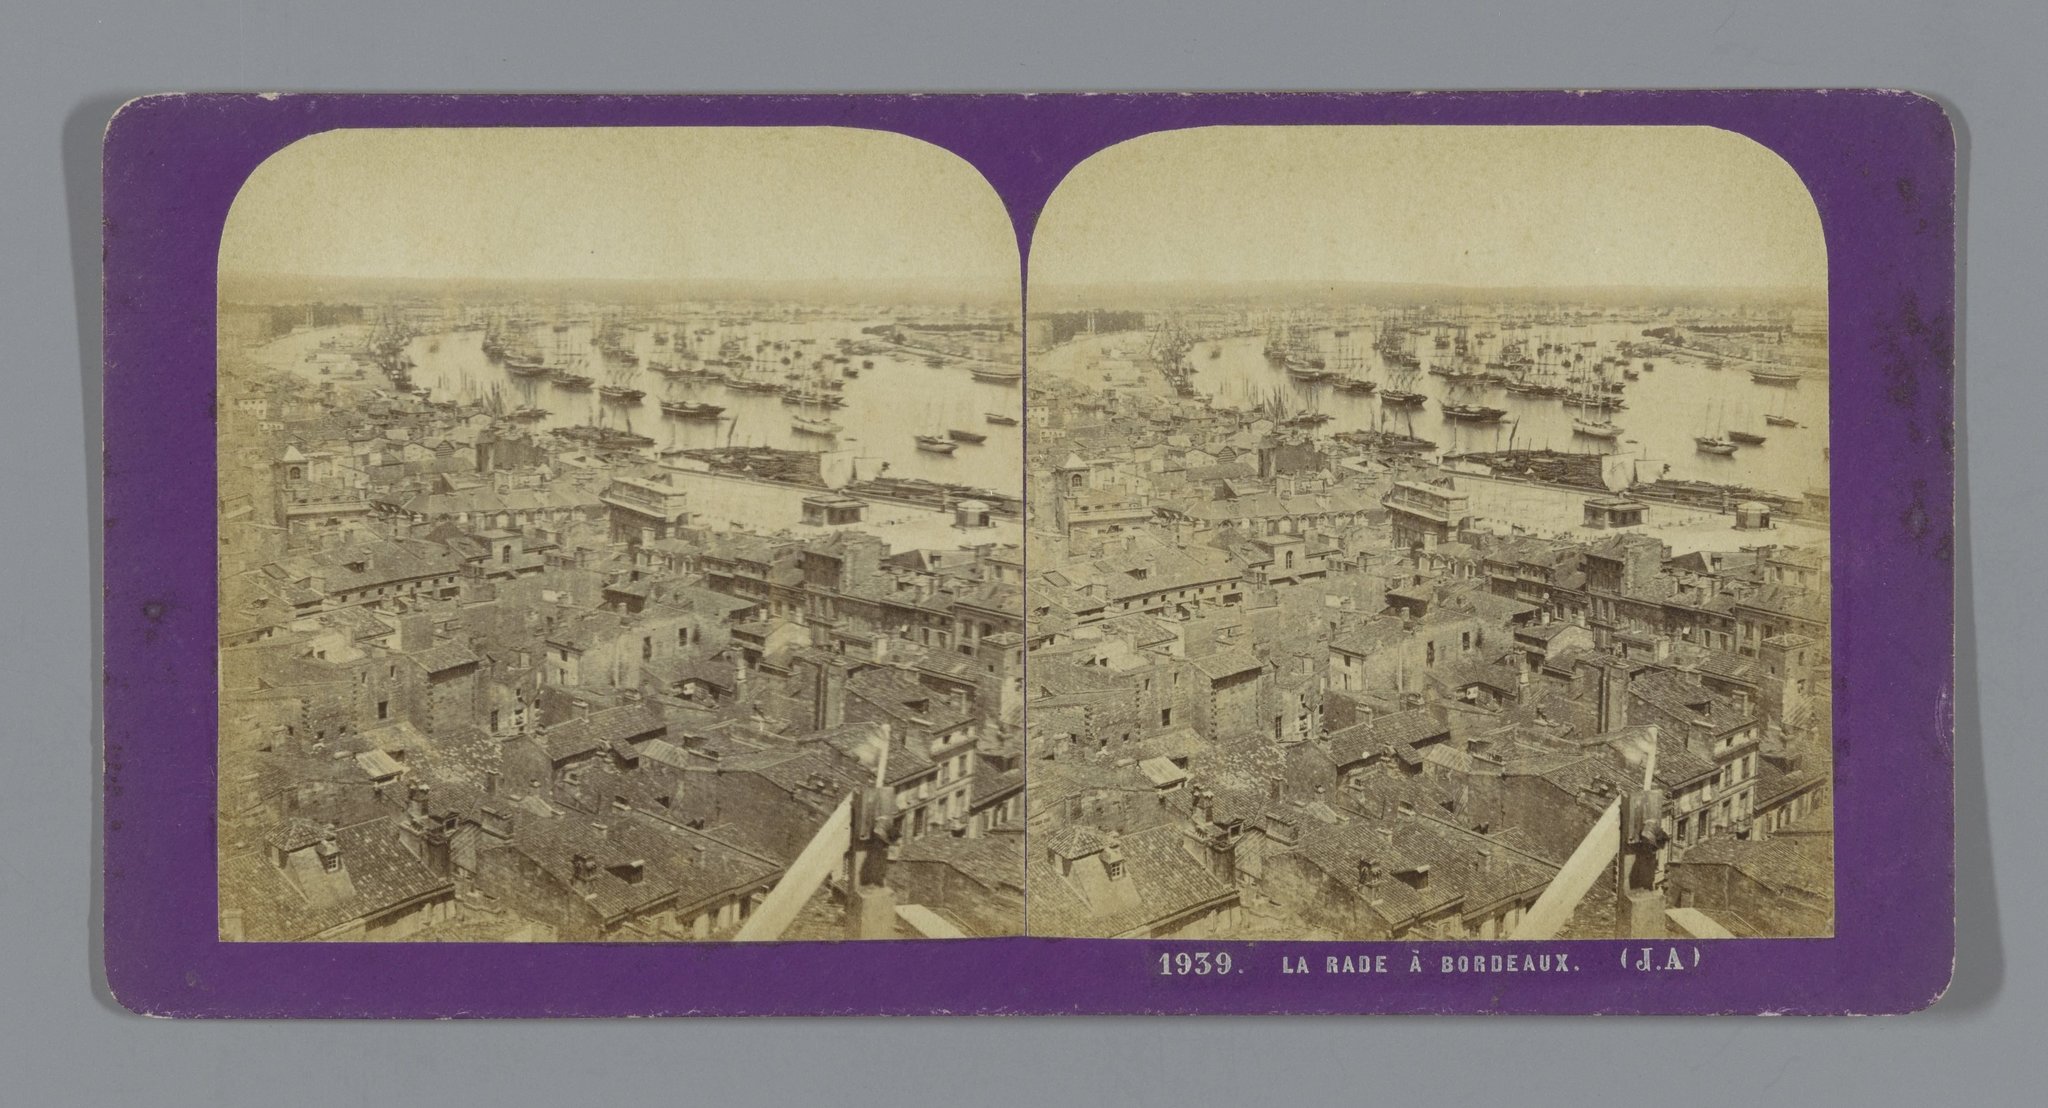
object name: stereograph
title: La Rade à Bordeaux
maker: jean andrieu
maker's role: fotograaf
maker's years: 1816-1872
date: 1862-1876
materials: cardboard, photographic support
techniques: albumen print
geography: bordeaux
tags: bordeaux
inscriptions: number: ‘1939.’